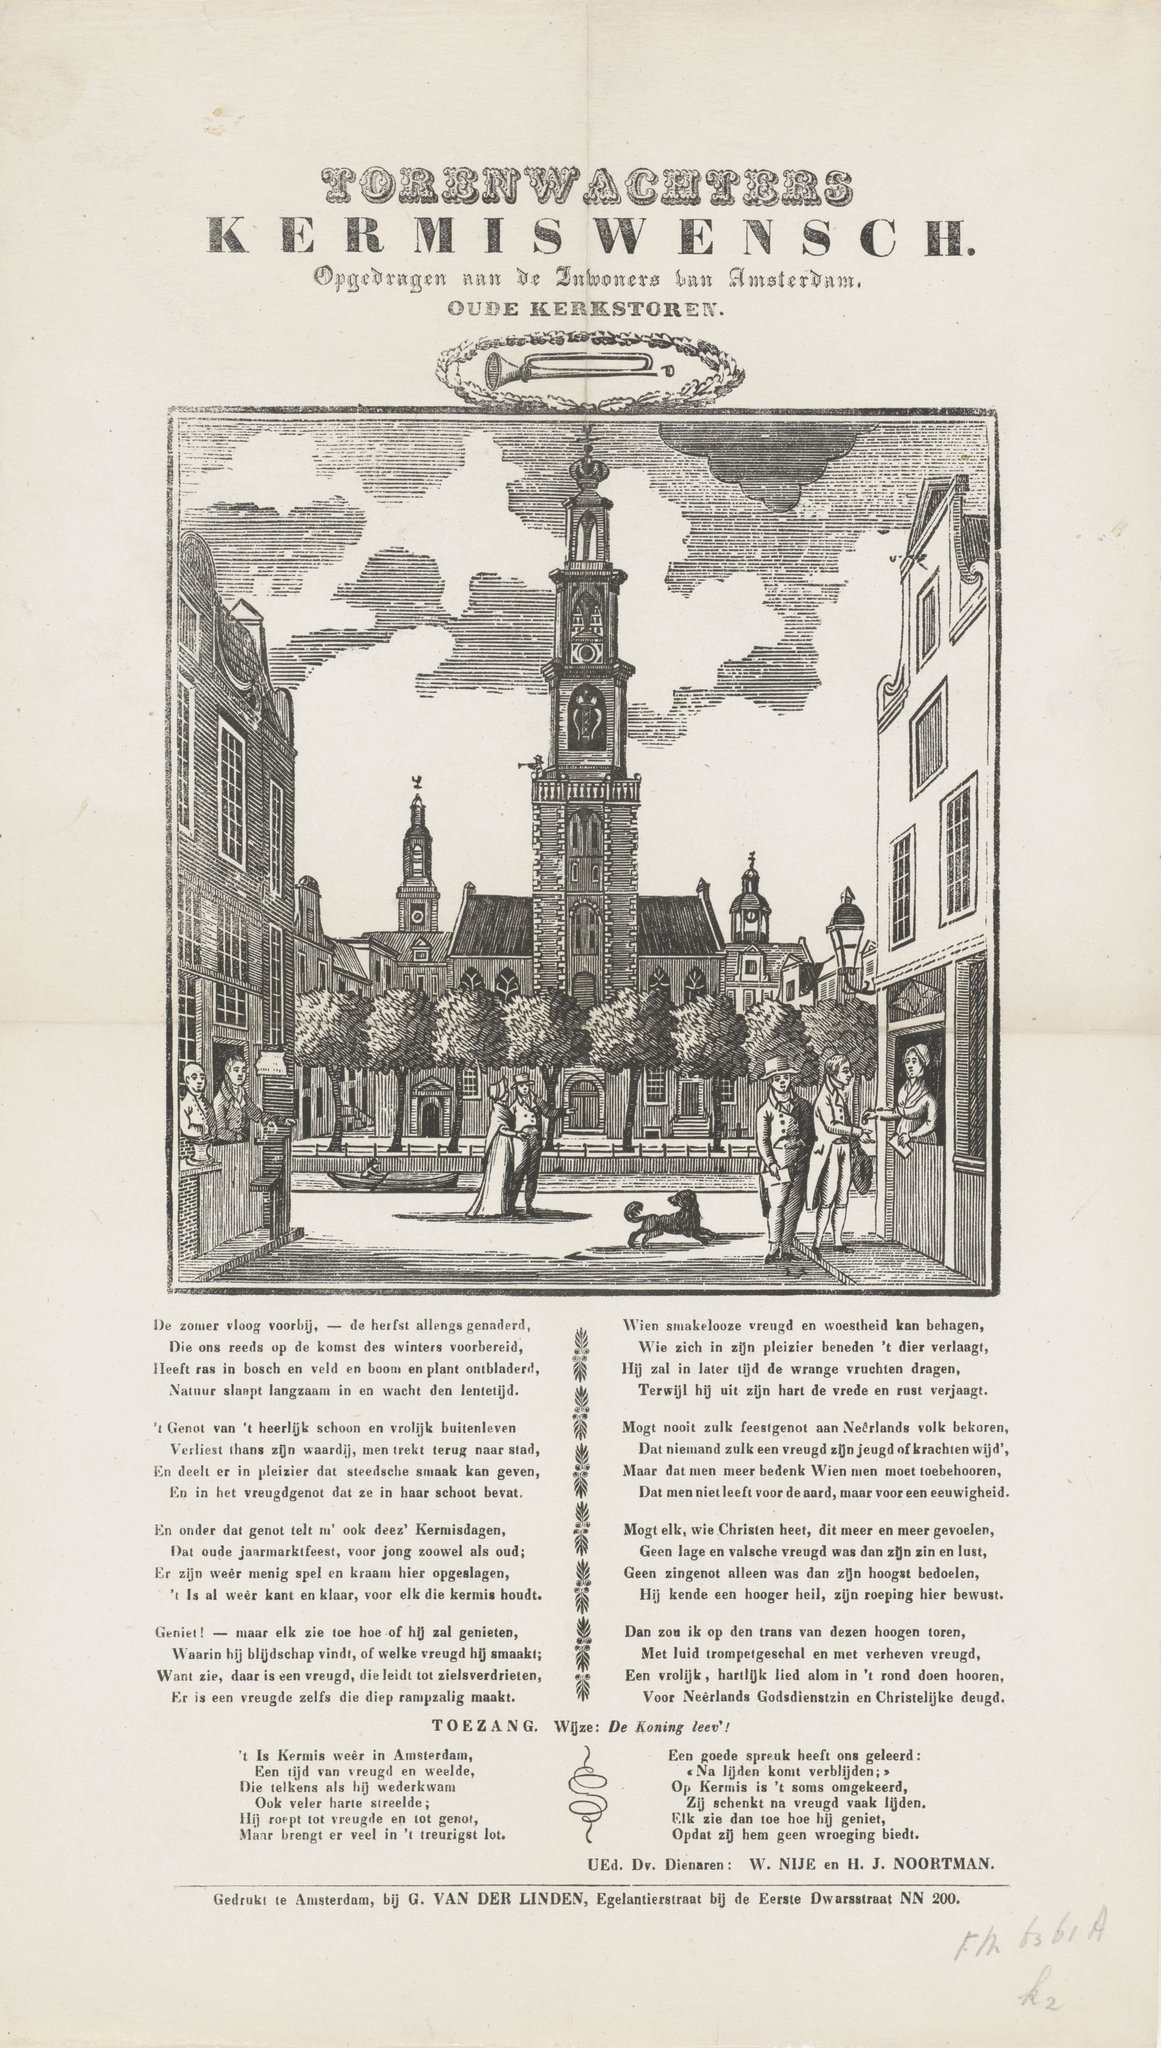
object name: fair print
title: Kermisprent van de torenwachters van de Oude Kerk te Amsterdam, ca. 1840-1870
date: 1840-1870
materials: paper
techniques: letterpress printing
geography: amsterdam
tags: tower sentry, street, amsterdam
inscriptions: collector's mark: Lugt 2228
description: Kermisprent van de torenwachters van de Amsterdamse Oude Kerk, ca. 1840-1870. Gezicht op de Westerkerk te Amsterdam, twee mannen halen aan de huizen geld op. Onderaan een vers in twee kolommen en een lied in twee verzen. Van de torenwachters: W. Nije en H.J. Noortman.